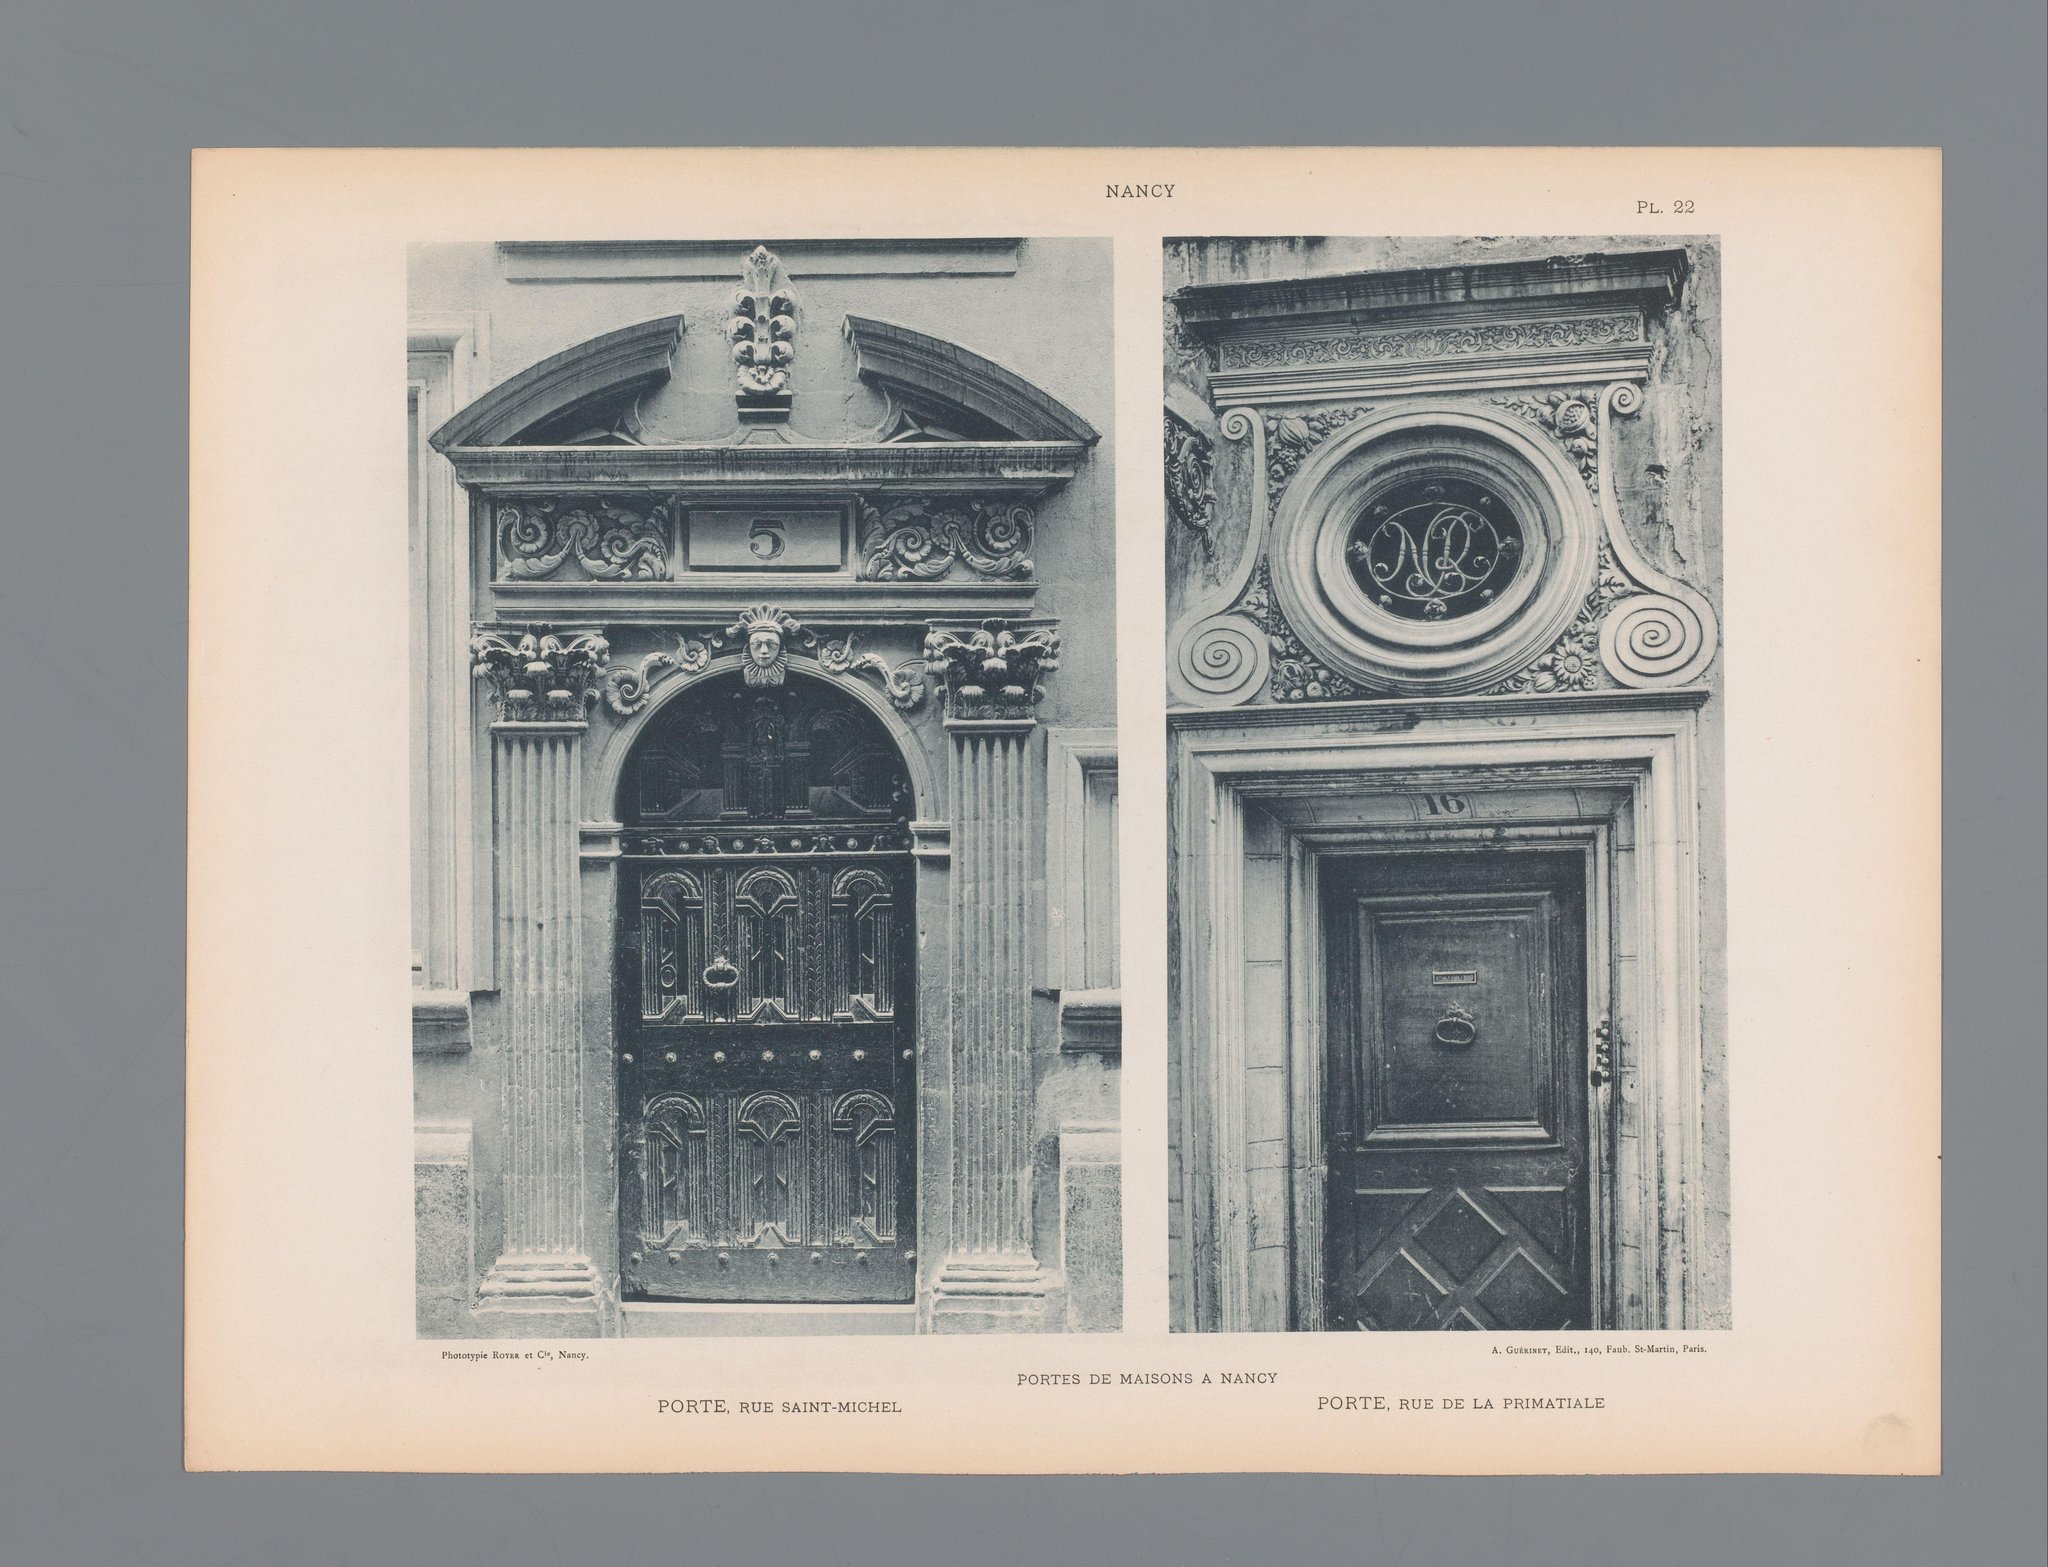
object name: photomechanical print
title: Twee ingangen van woonhuizen te Nancy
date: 1891-1896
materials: paper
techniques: photograph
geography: paris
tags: urban housing, gate, entrance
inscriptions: inscription: ‘Portes de maisons a Nancy (...)’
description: Deze prent maakt deel uit van een omslag met 103 prenten op 101 bladen en een titelblad.